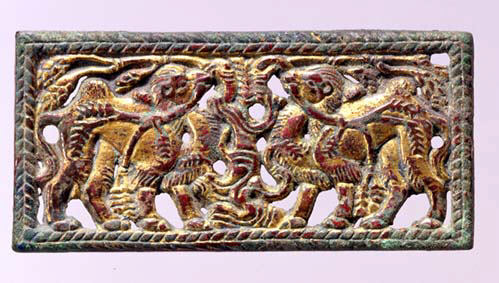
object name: belt buckle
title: Belt Buckle with Bactrian Camels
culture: north chinese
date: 200-101 BCE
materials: bronze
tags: camels